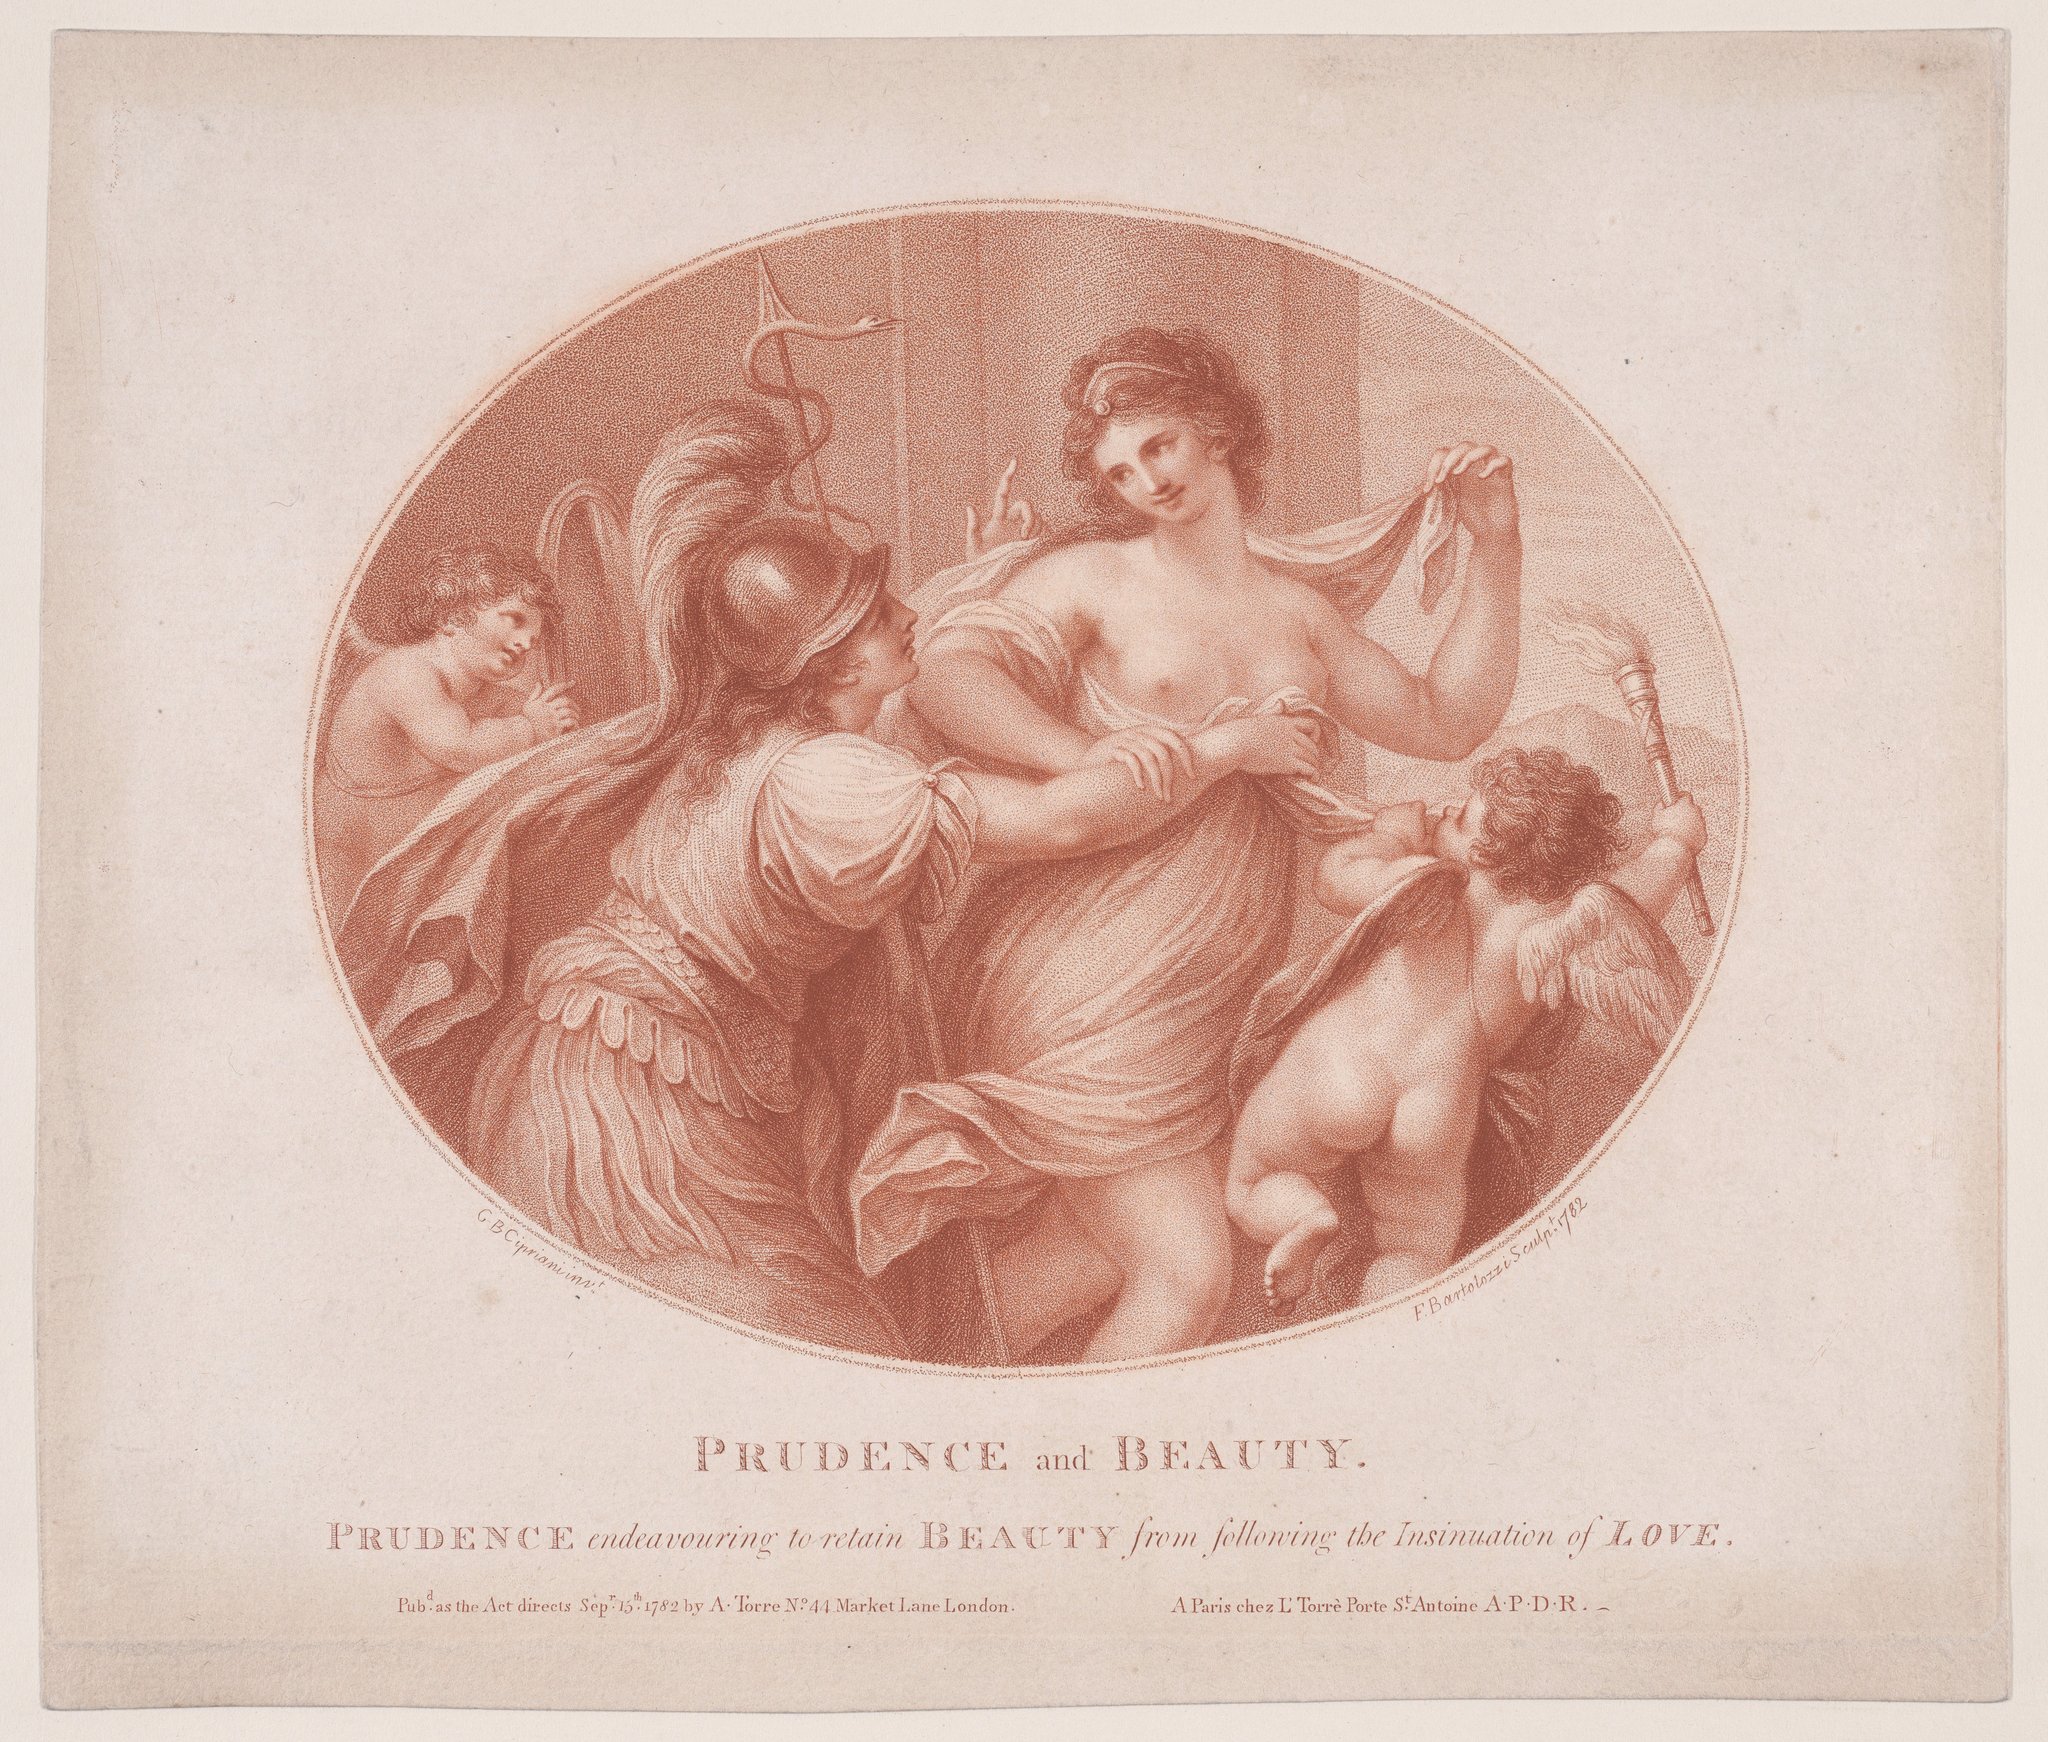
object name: print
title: Prudence, Love and Beauty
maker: francesco bartolozzi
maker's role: artist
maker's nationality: italian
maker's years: 1728-1815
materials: ink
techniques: etching, printing, engraving